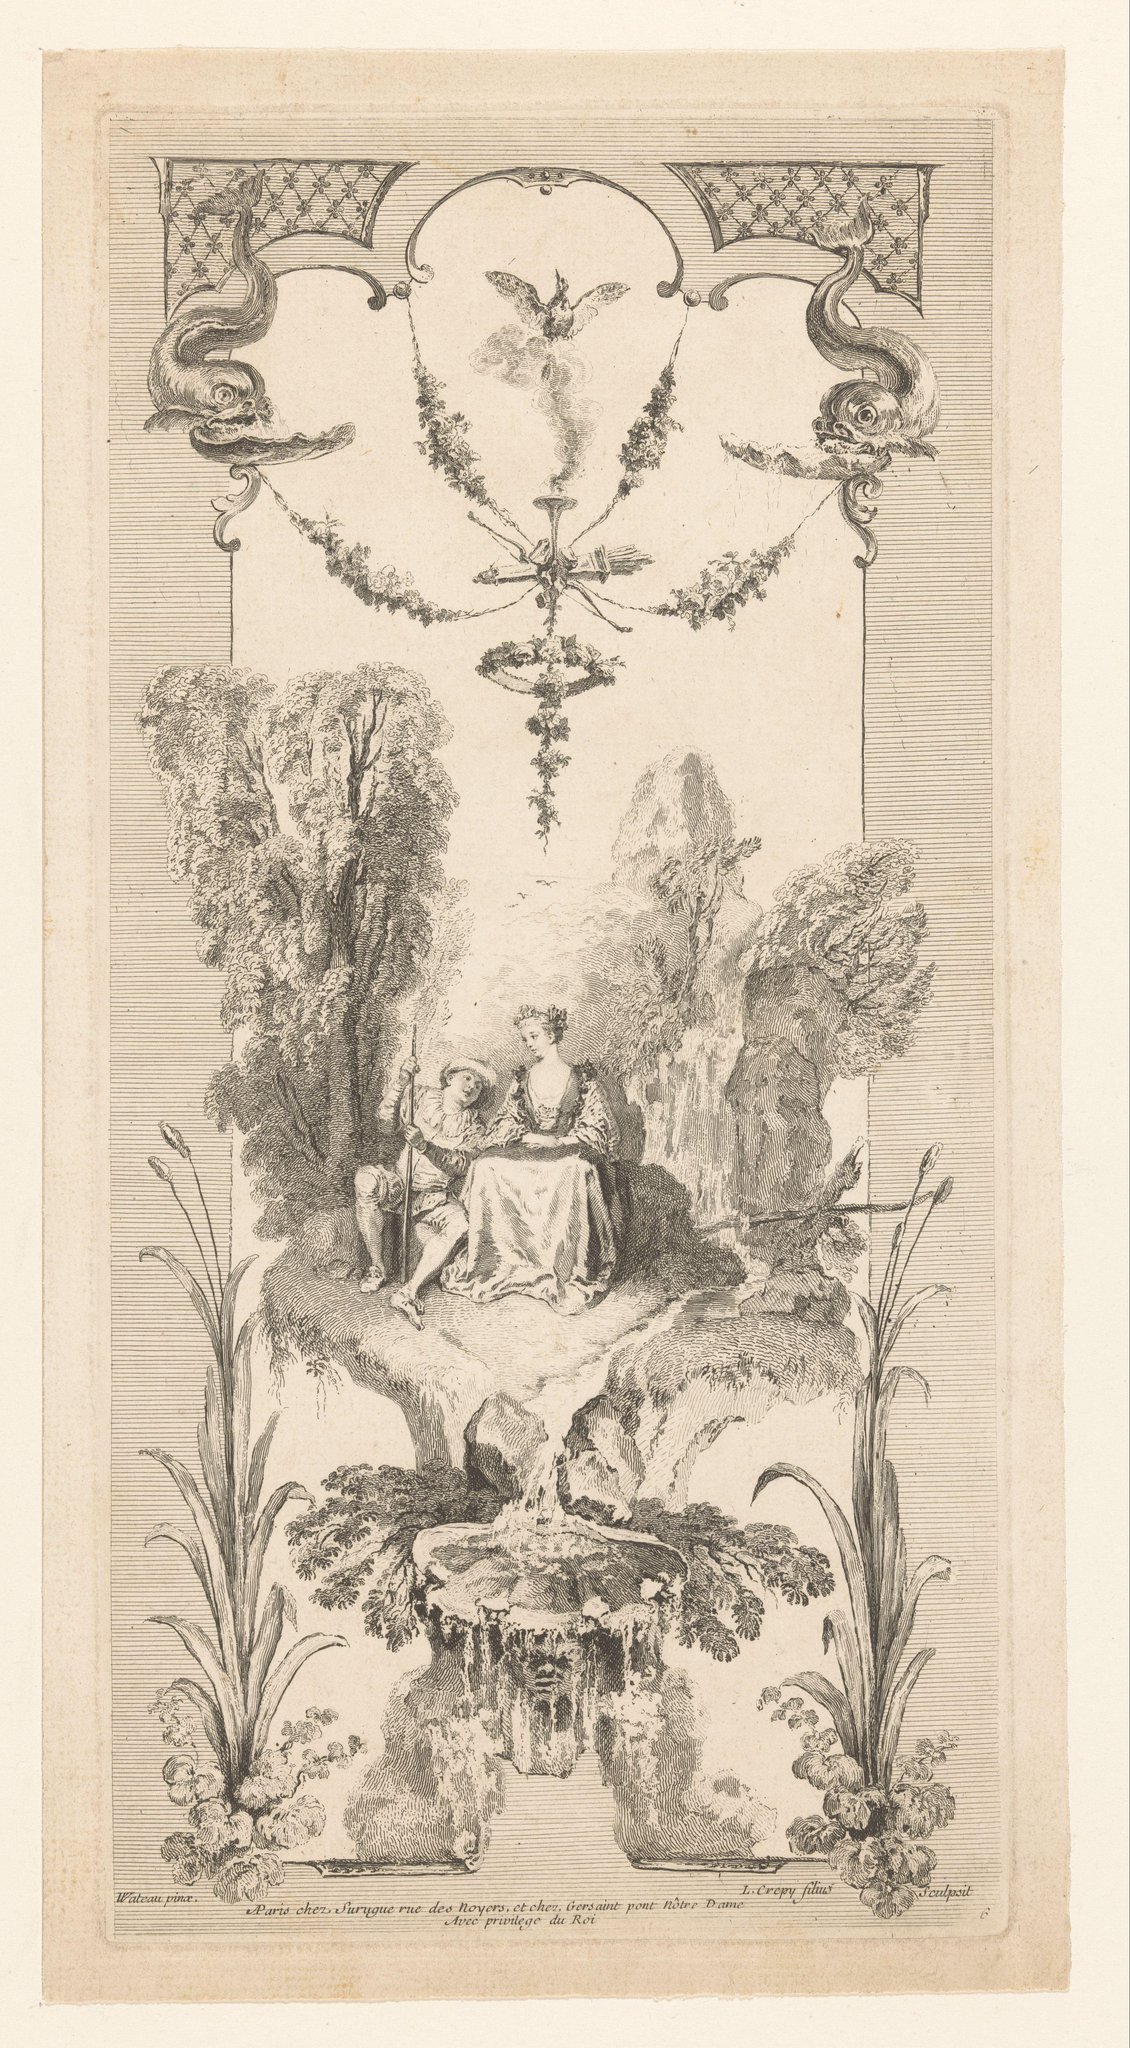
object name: ornament print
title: Verliefd paar in landschap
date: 1728-1740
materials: paper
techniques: etching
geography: paris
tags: landscapes (+ landscape with figures, staffage), couple of lovers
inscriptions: collector's mark: Lugt 2228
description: Een verliefd paar zit in een landschap bij een waterval. Rondom de voorstelling een ornamentele omlijsting met dolfijnen, een trofee met fakkel, pijlenkoker en boog, guirlandes, een bloemenkrans en lisdodden.